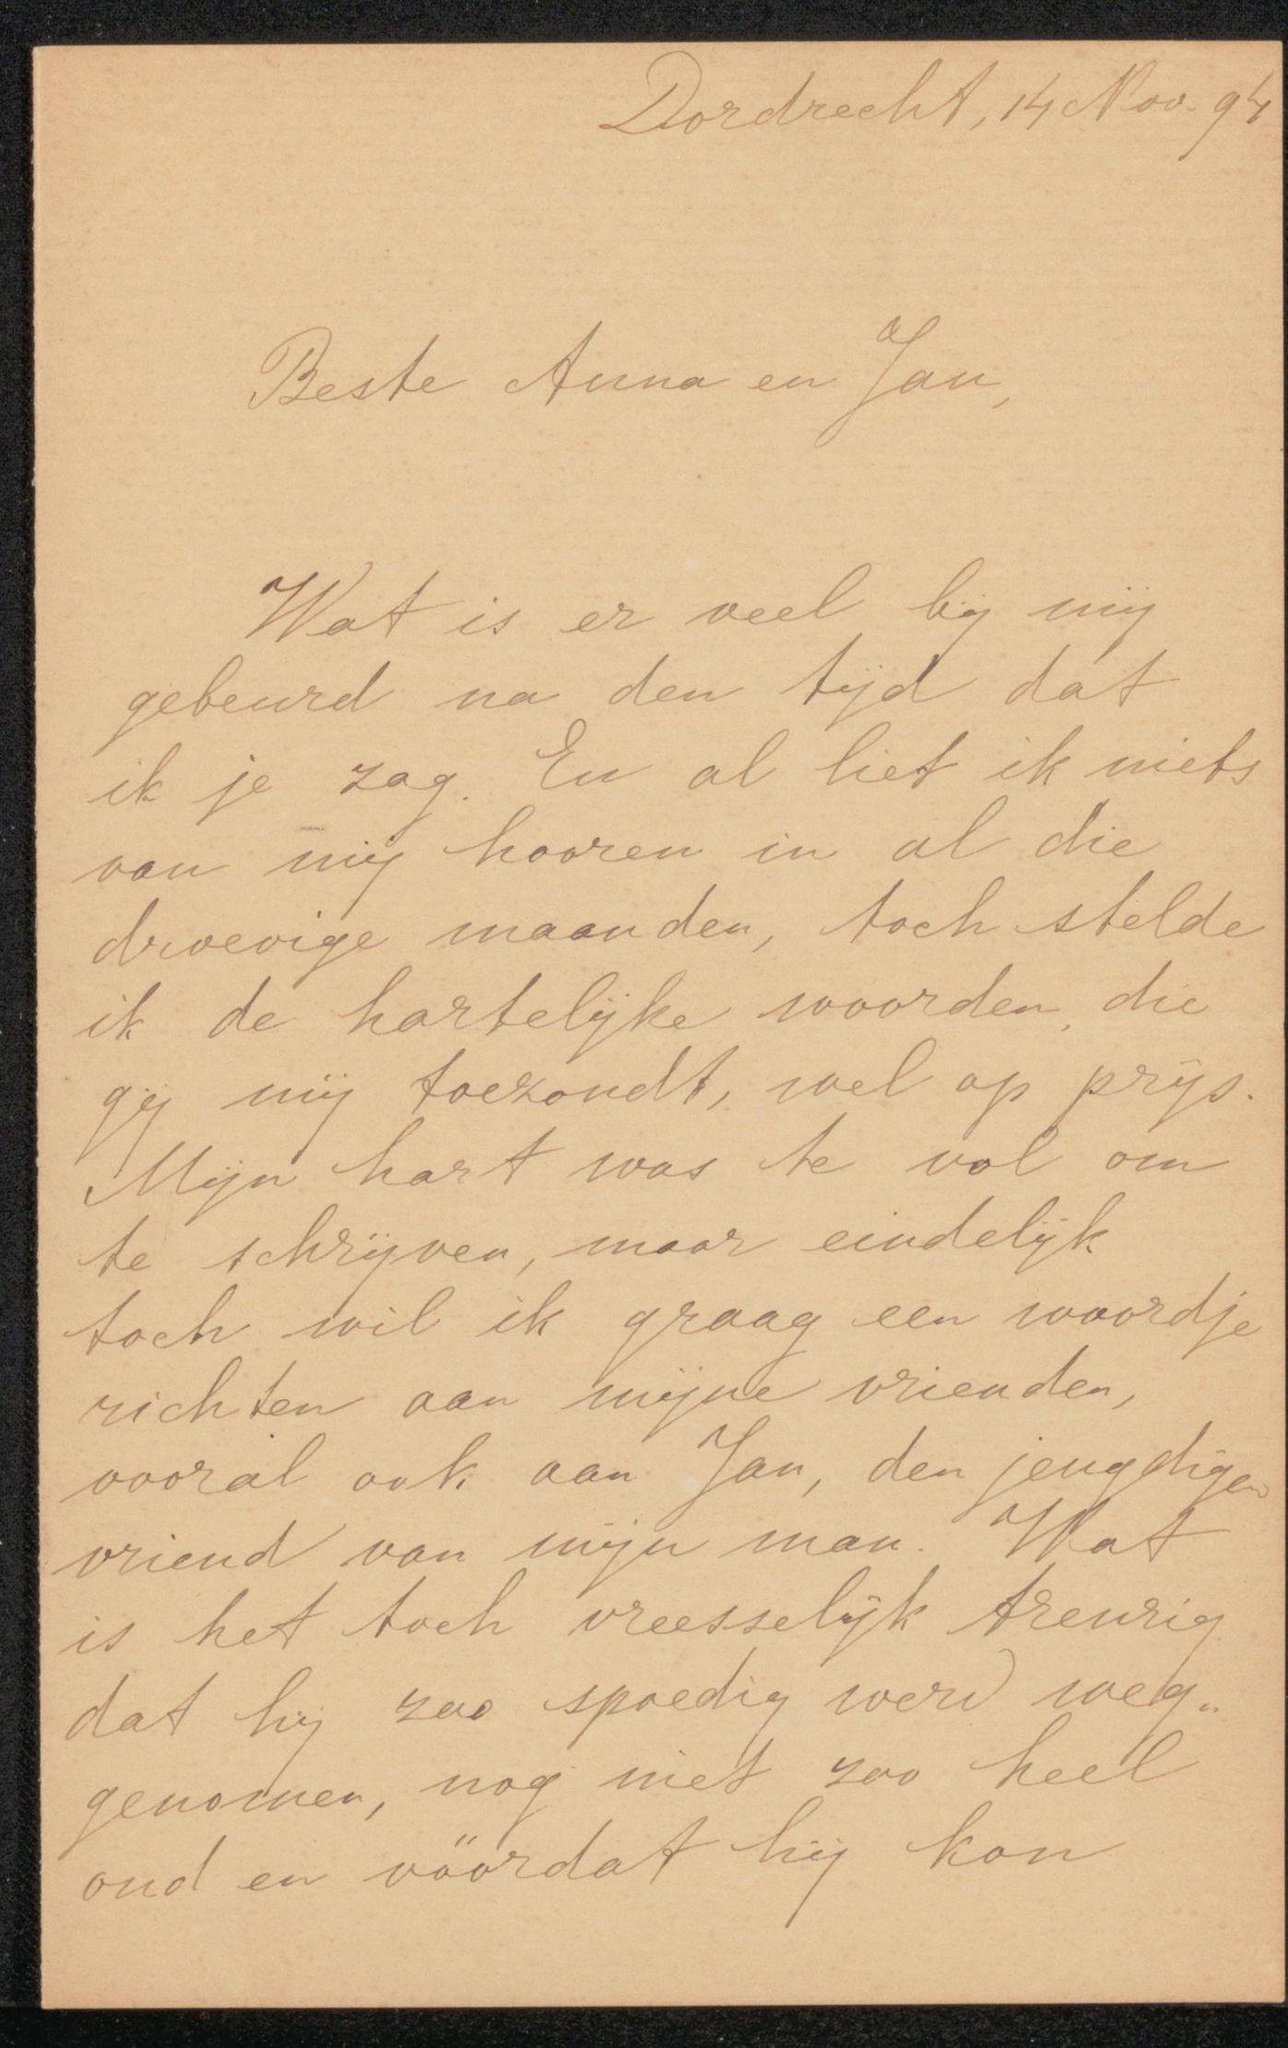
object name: letter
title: Brief aan Anna Dorothea Dirks en Jan Veth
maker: elizabeth lebret-giltay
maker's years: 1845-1936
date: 1894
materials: ink, paper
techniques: pen, writing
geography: dordrecht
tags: dordrecht, amsterdam, painter, draughtsman, designer, jan veth, artist, anna dorothea dirks, passions, emotions, affections, family life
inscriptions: collector's mark: ‘RPK’